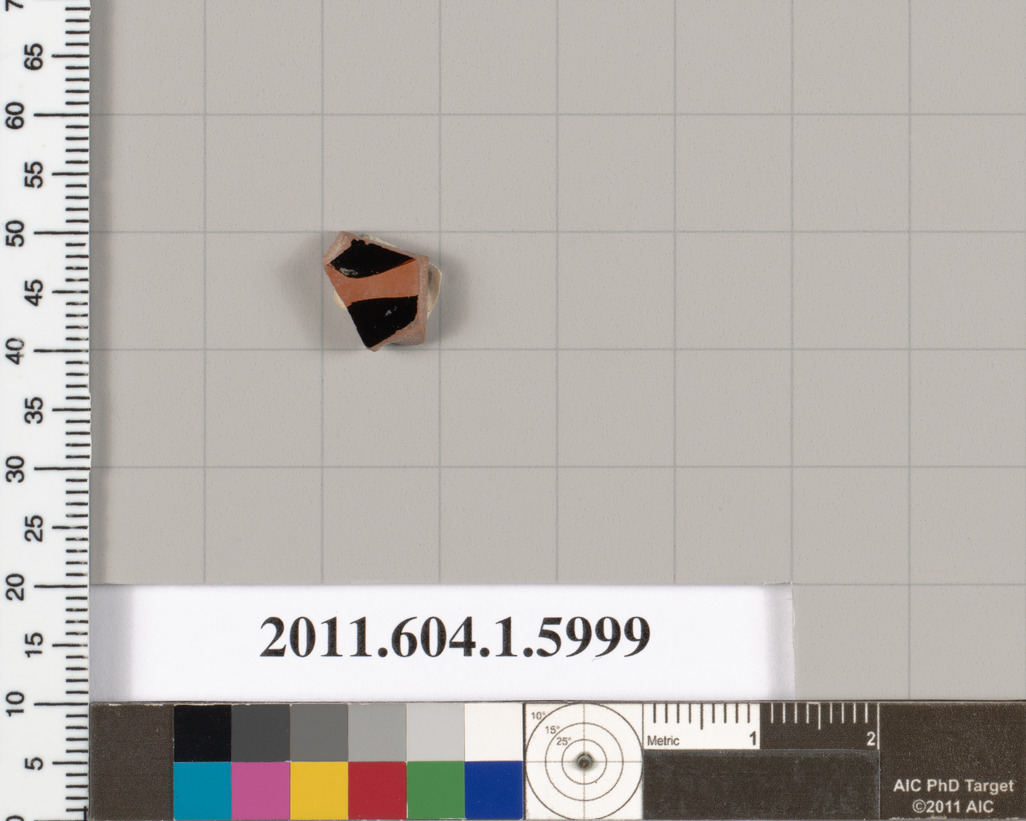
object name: kylix fragment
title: Terracotta fragment of a kylix (drinking cup)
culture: greek, attic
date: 510-500 BCE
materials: terracotta